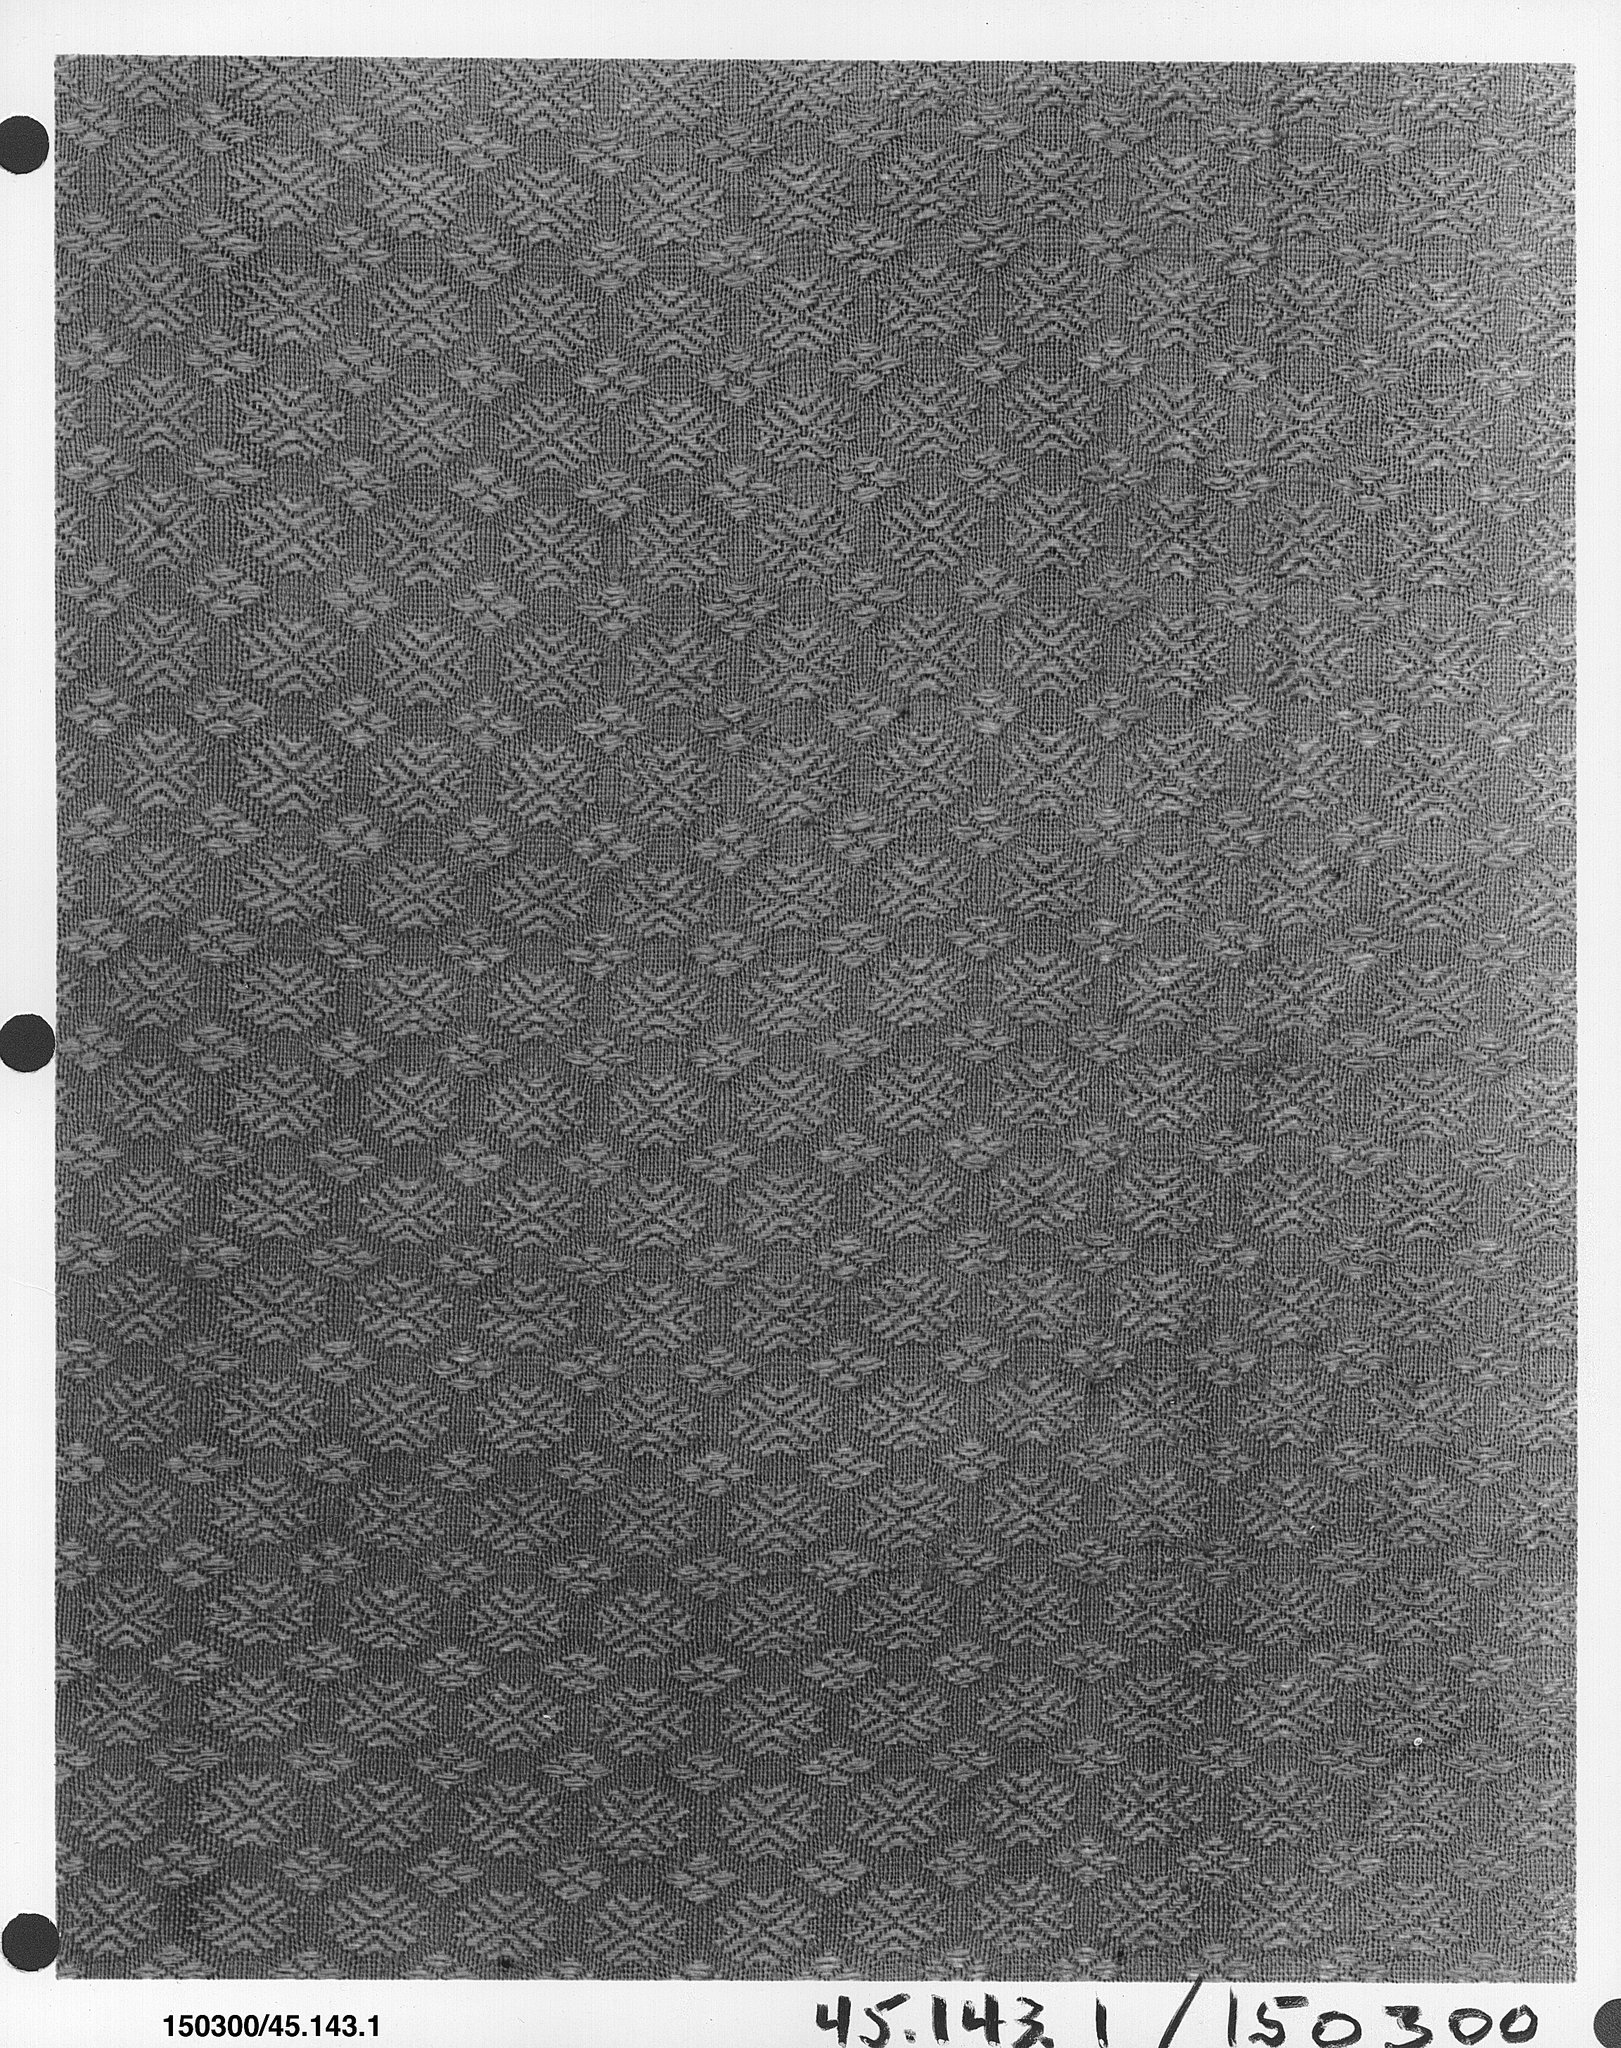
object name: towel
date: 1835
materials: linen